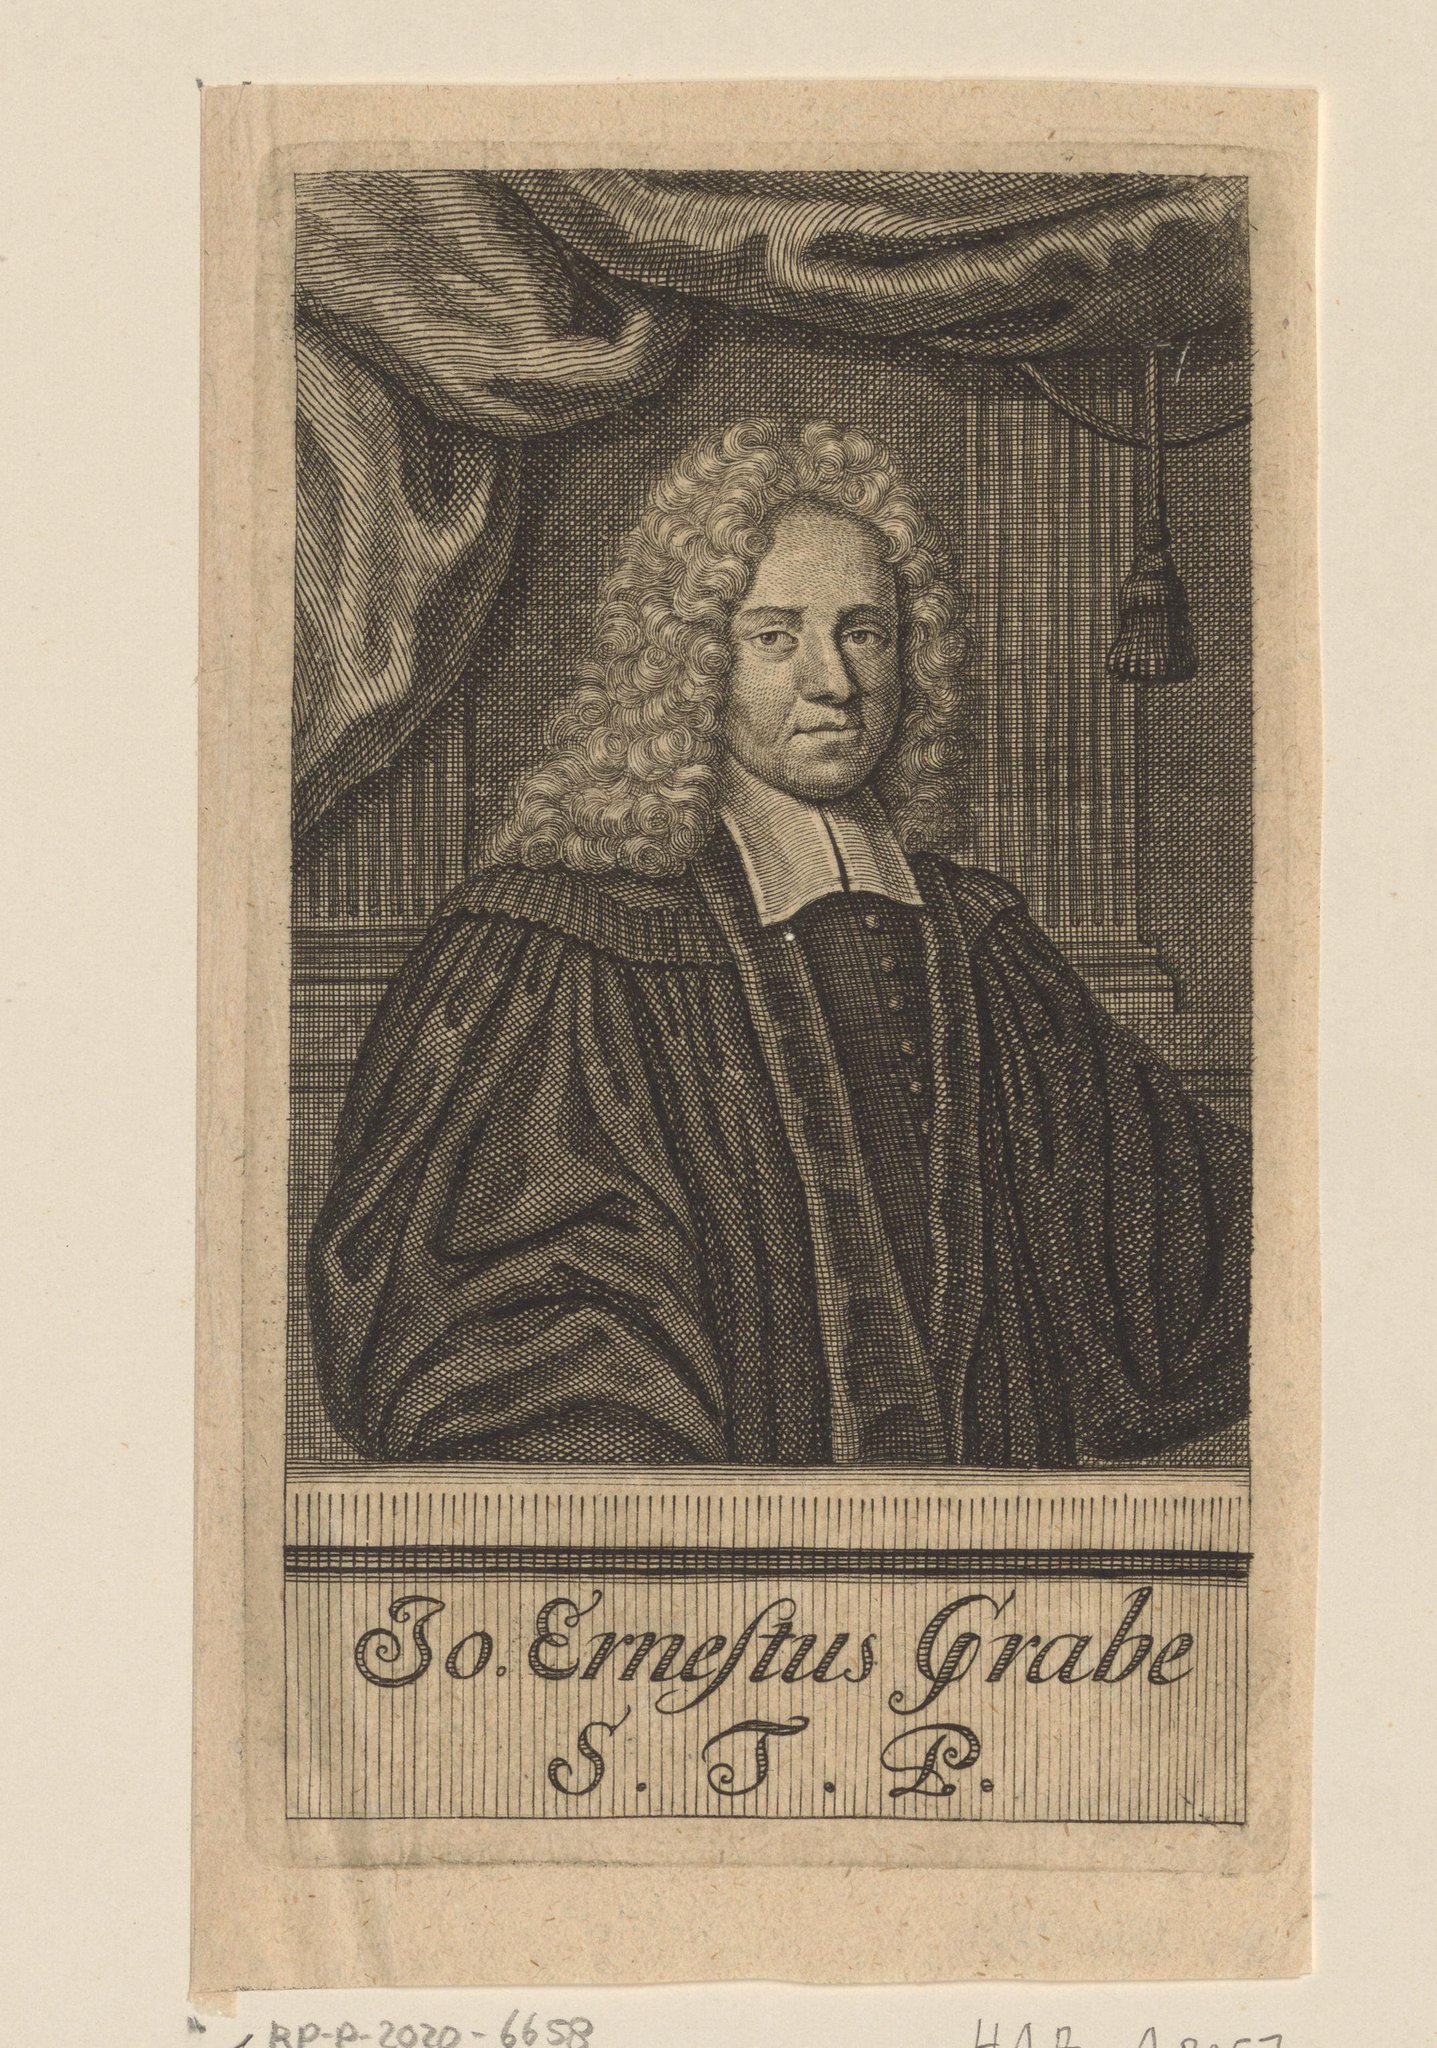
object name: print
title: Portret van Johann Ernest Grabe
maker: johann georg mentzel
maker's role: print maker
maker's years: 1677-1743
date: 1687-1710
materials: paper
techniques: engraving, etching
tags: theologian, historical persons